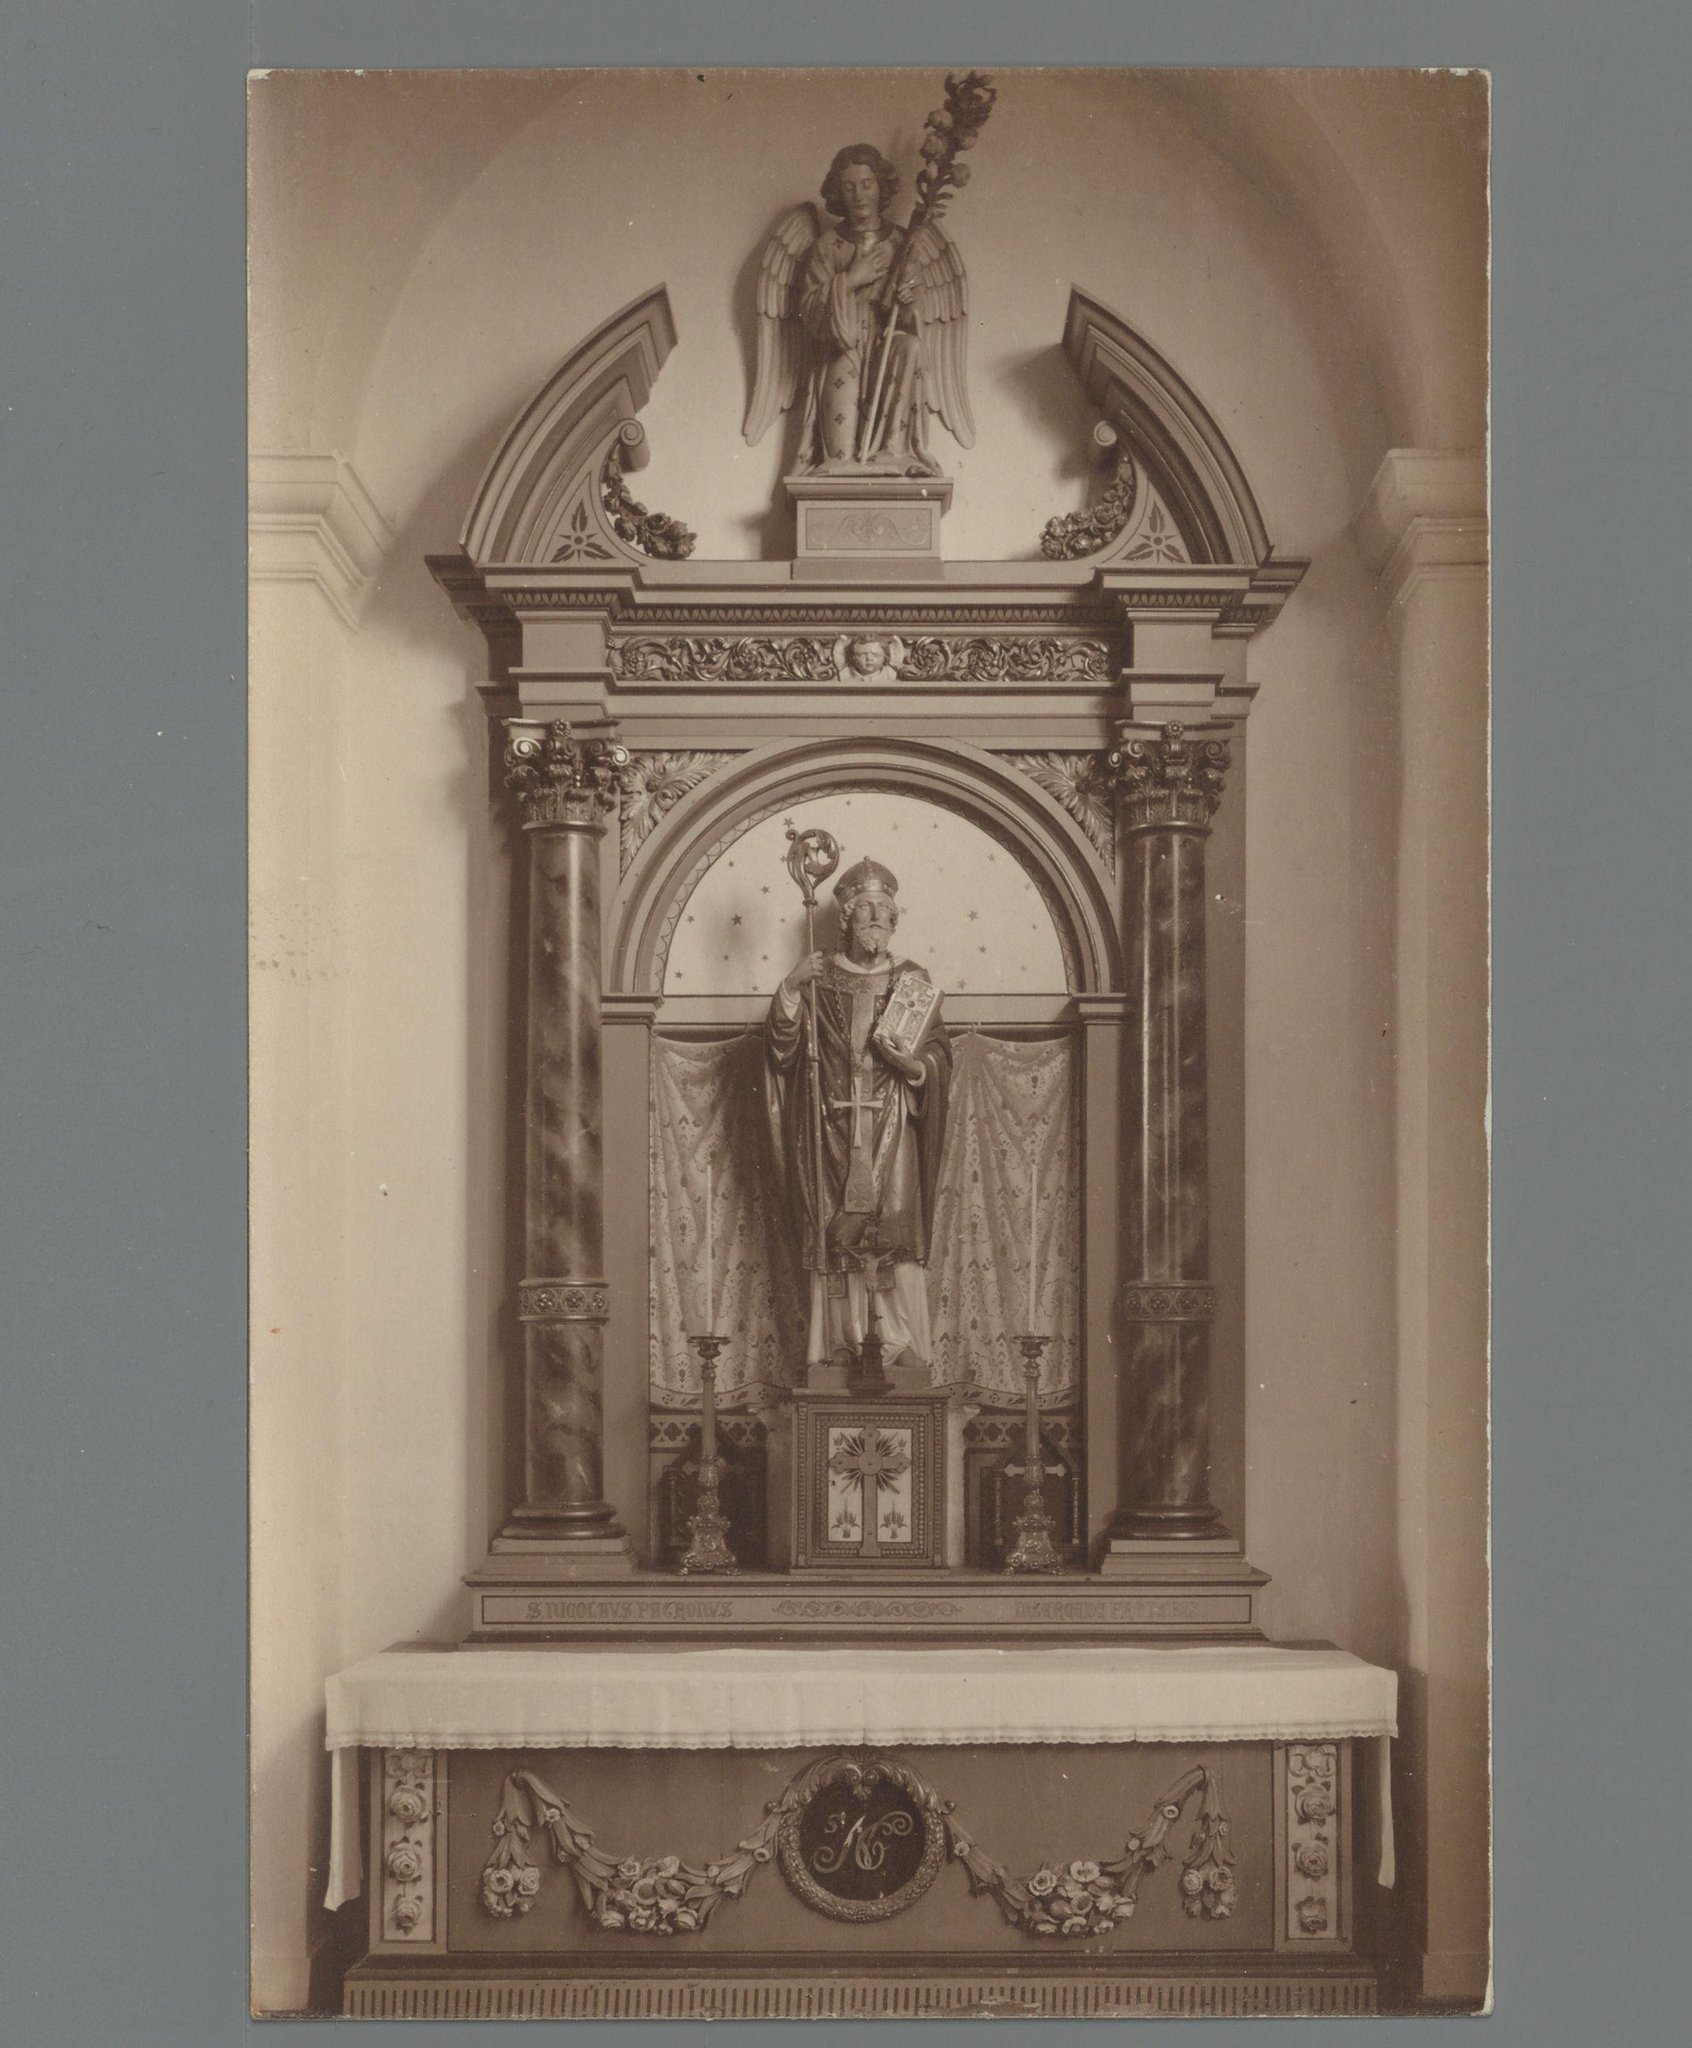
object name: ansichtkaart, prentbriefkaart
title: Beeld van de heilige Nicolaas in een kerk te Edam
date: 1906-1931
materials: photographic support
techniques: collodion silver print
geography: edam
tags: saints, interior of church, monument, statue, vault ~ architecture